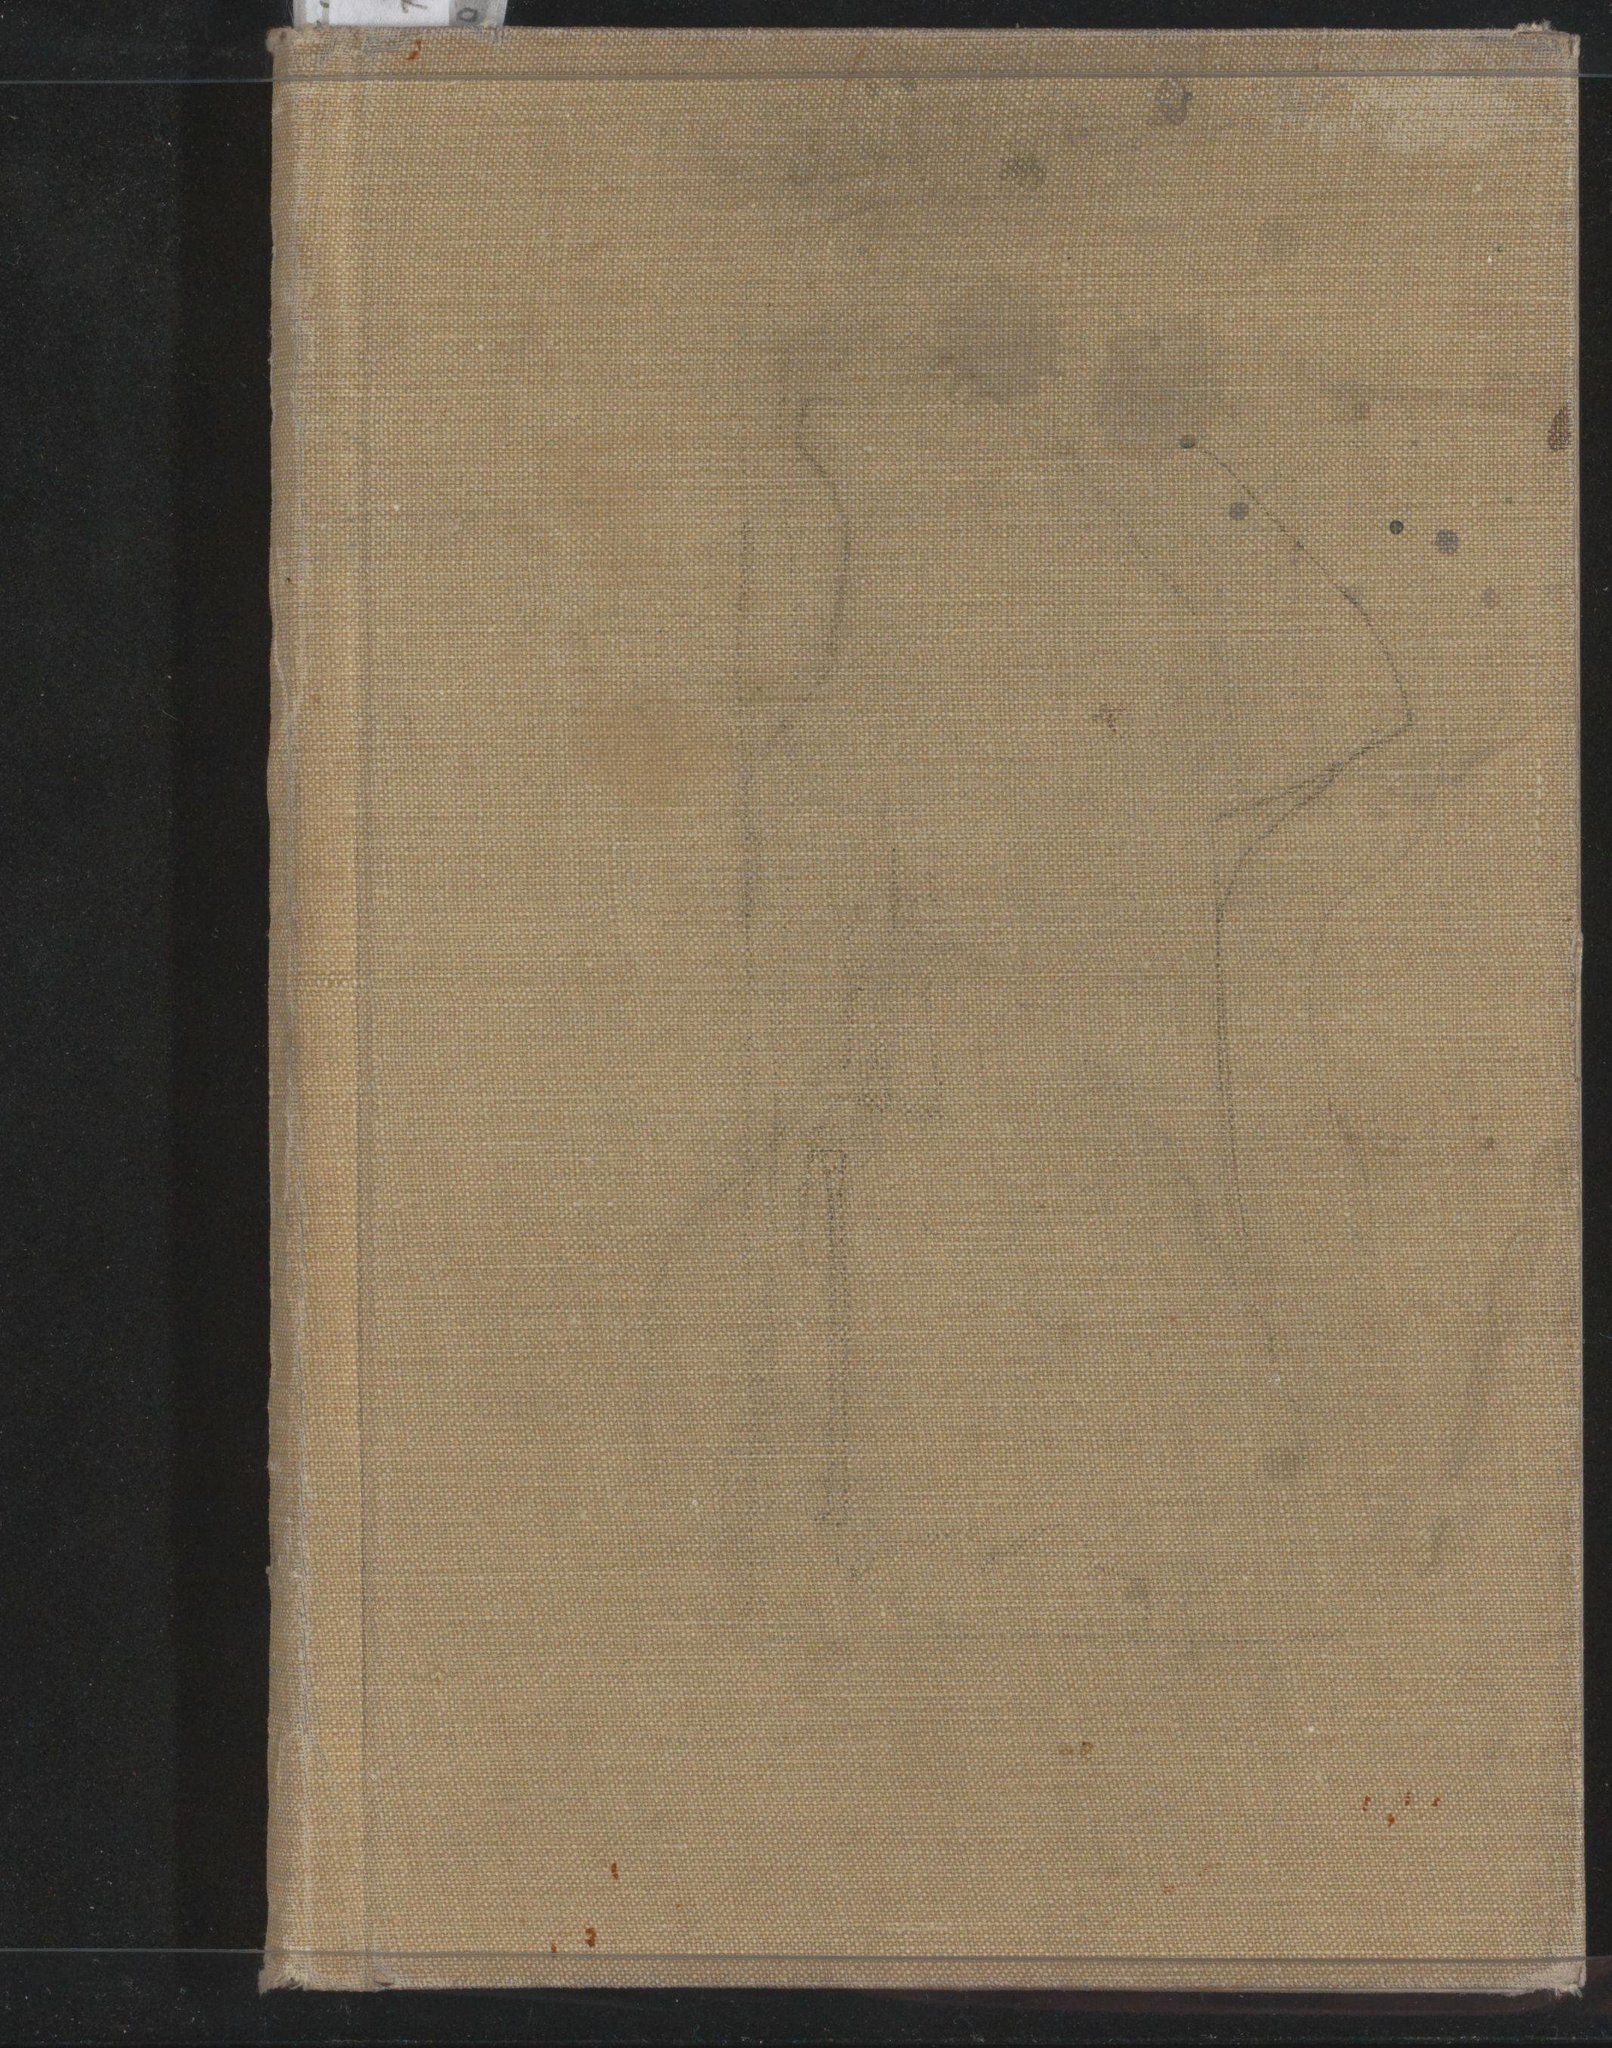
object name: sketchbook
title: Schetsboek met 73 bladen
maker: cornelis vreedenburgh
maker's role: draughtsman, print maker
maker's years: 1880-1946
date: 1935-1936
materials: cardboard, chalk, ink, linen, paper, pencil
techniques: pen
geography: venice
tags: ships (in general), folk costume, regional costume, street (+ city(-scape) with figures, staffage), venice, amsterdam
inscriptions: factory mark: ‘SKETCHER'S/ NOTE BOOK/ SERIES A 42/ containing 80 leaves of good white paper./ MANUFACTURED BY/ GEO. ROWNEY & CO., LONDON, W., ENGLAND/ SIZE No. 2- 8 1/2 x 5 1/2 inches./ Dimensions de l'album 14 x 10 cm.’, collector's mark: Lugt 2228a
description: Schetsboek bestaande uit 73 bladen met voornamelijk stadsgezichten, landschappen en figuren, deels gemaakt tijdens een bootreis, vermoedelijk de reis van Vreedenburgh naar het Midden-Oosten via Italië en Egypte in 1936. Tevens enkele Amsterdamse stadsgezichten en ontwerpen voor een affiche voor Jachthaven S. van Dijk in Oud-Loosdrecht. Op de voor- en achterzijde van het schetsboek potloodstudies.